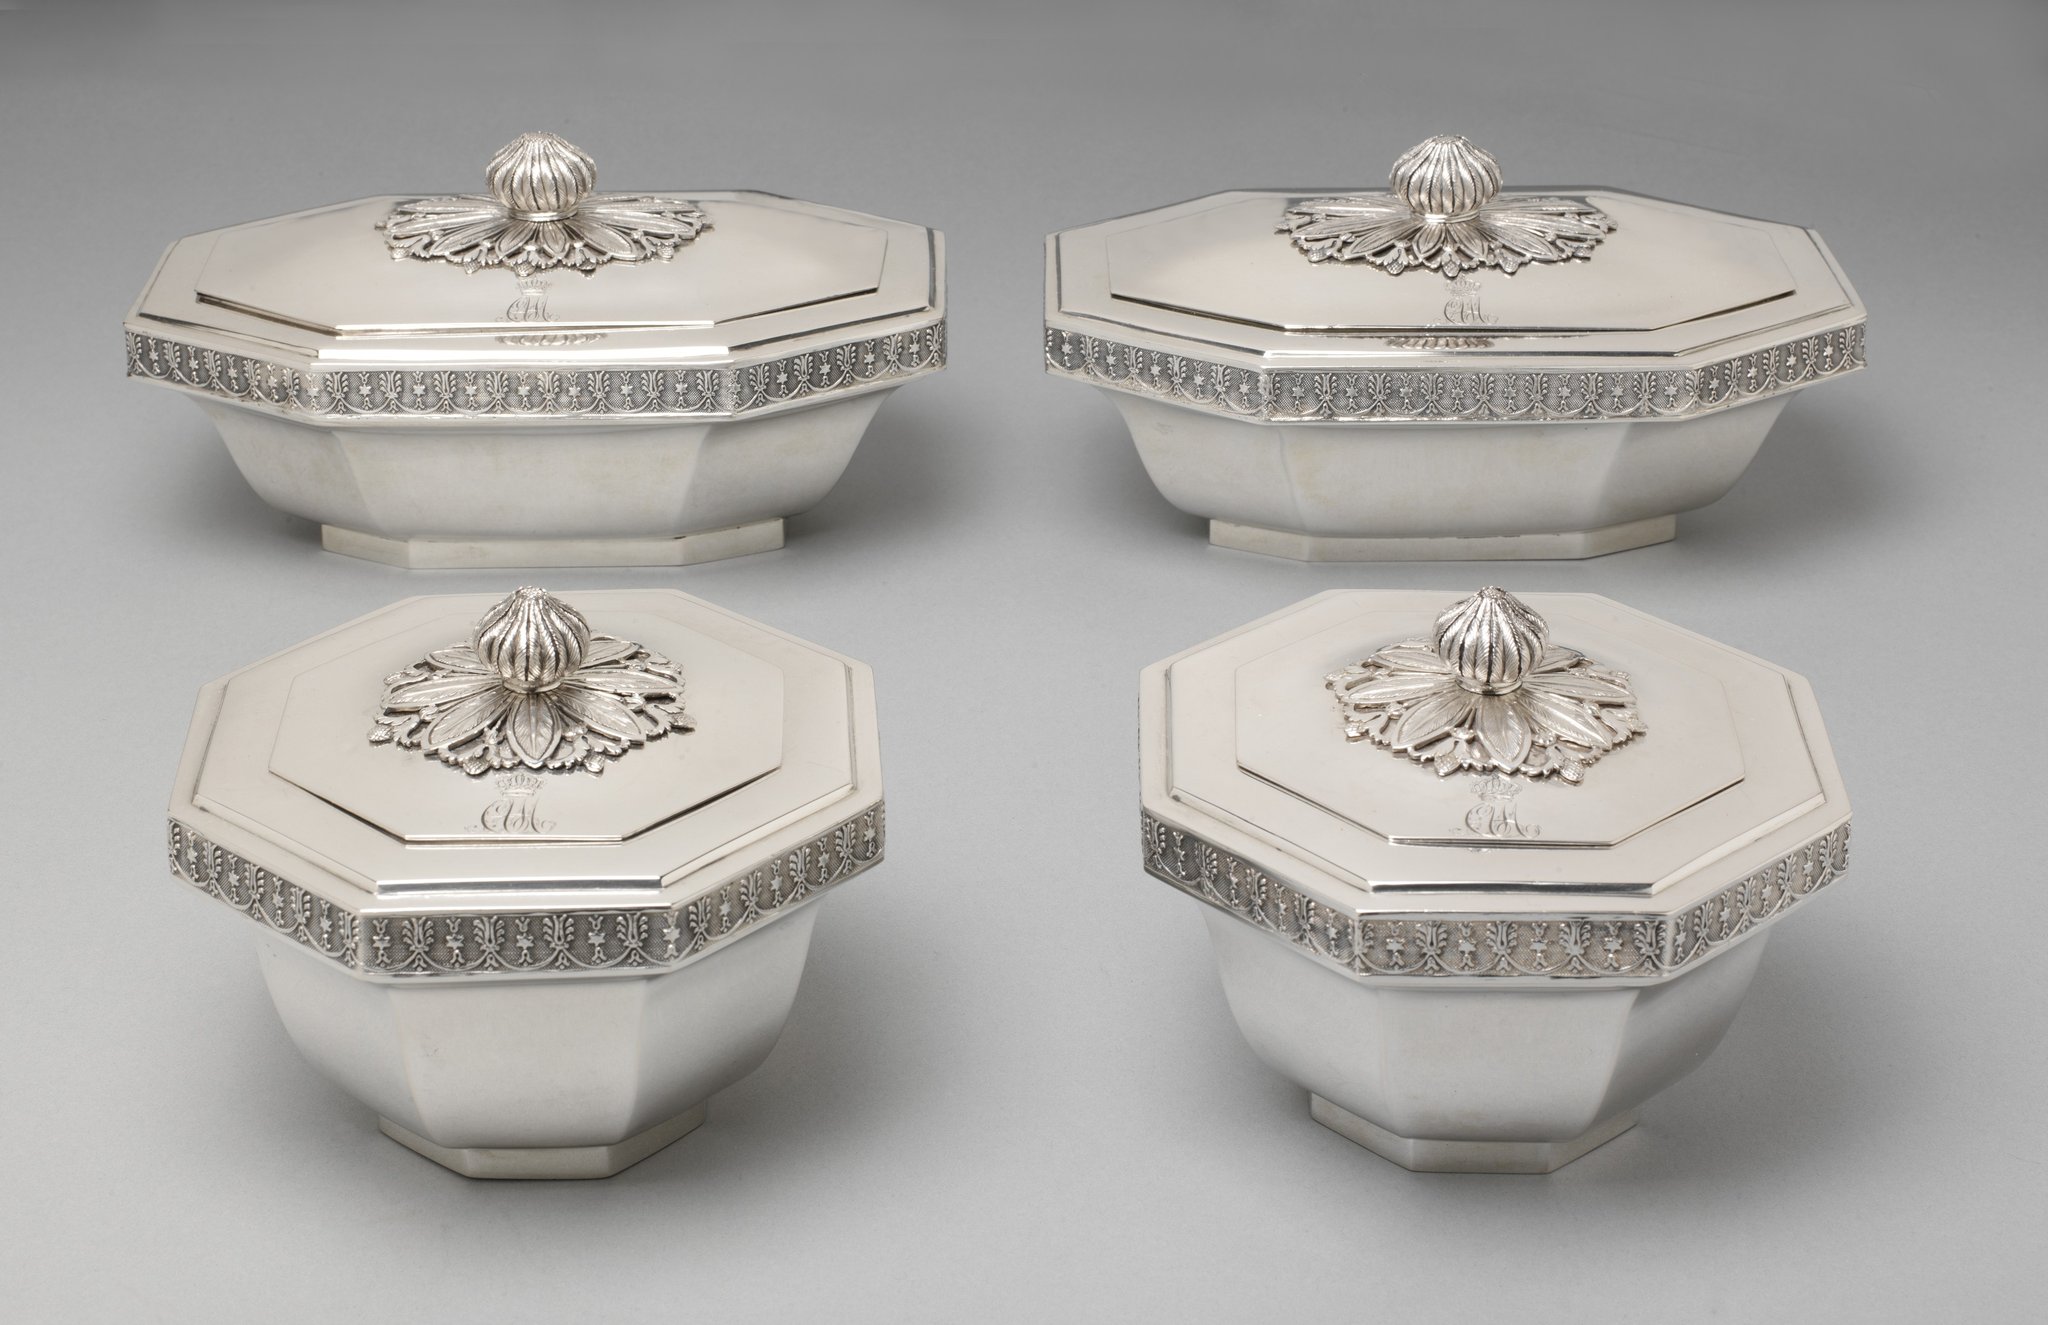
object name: box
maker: johann christian sick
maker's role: maker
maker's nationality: german (stuttgart)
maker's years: 1766-1824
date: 1800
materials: silver